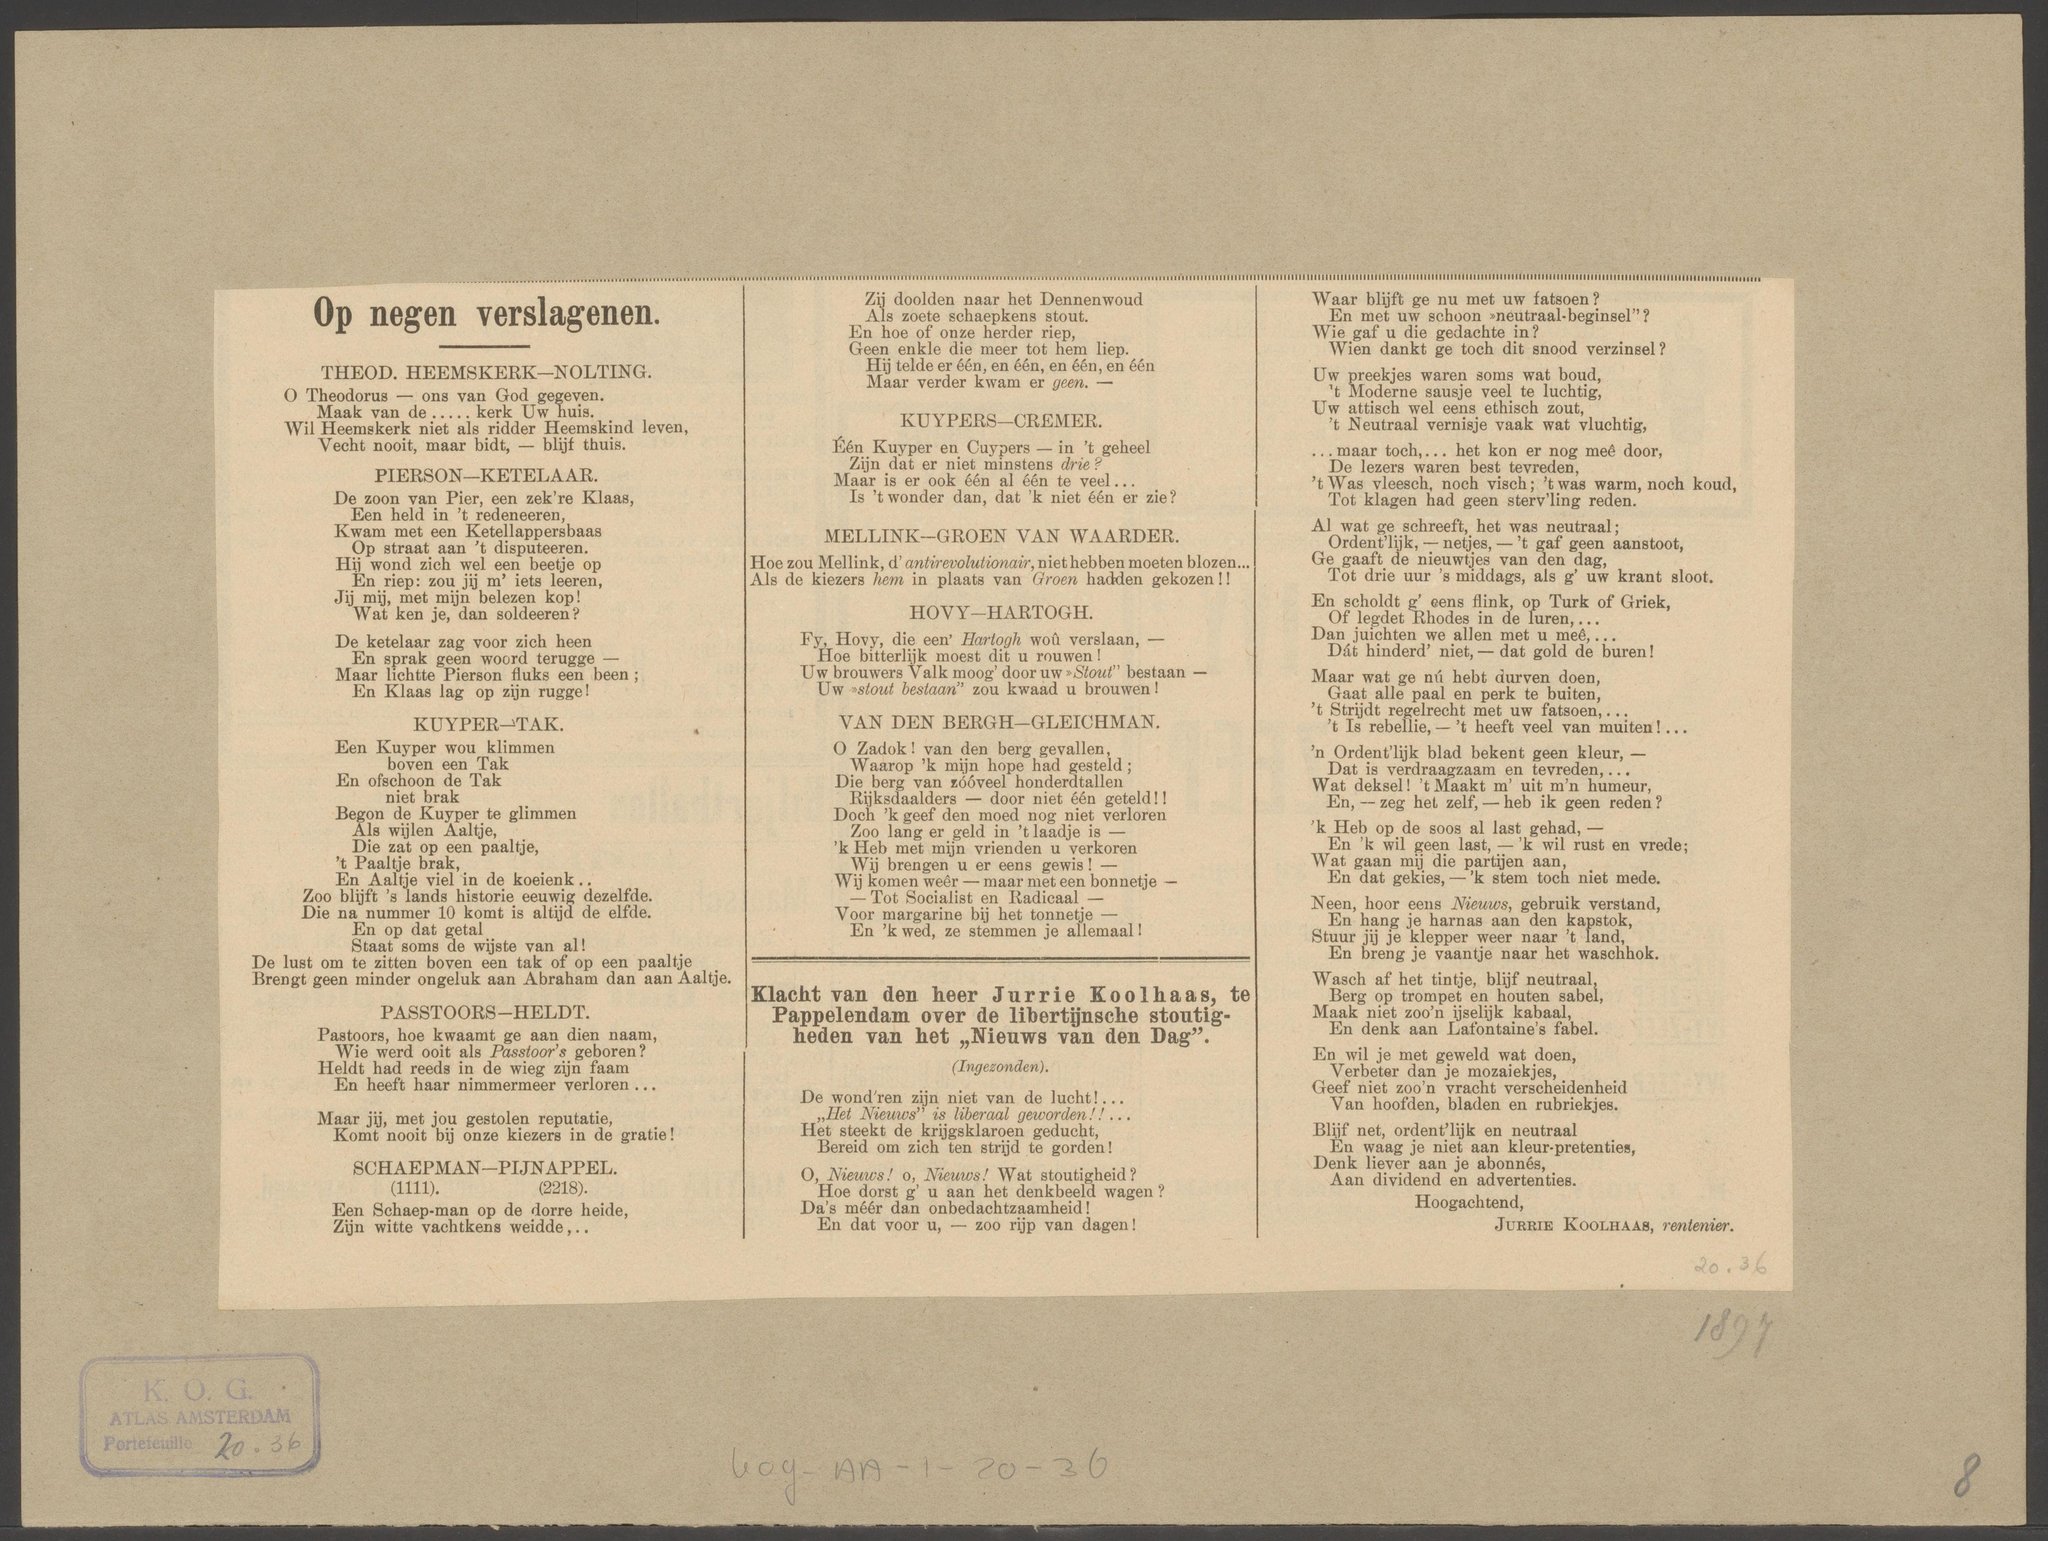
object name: text sheet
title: Hekeldichten op kandidaten van de Amsterdamse kiesdistricten voor de Tweede Kamerverkiezingen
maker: Anonymous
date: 1897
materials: paper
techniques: letterpress printing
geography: amsterdam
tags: nicolaas gerard pierson, rotterdam, zeist, oss, abraham kuyper, amsterdam, utrecht, rome, priest, herman johannes aloysius maria schaepman, arnhem, furniture worker, the hague, politician, voting, election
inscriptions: collector's mark: Lugt 1641b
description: Onderwerpsrubriek binnen de Atlas Amsterdam: Verkiezingen Tweede Kamer.